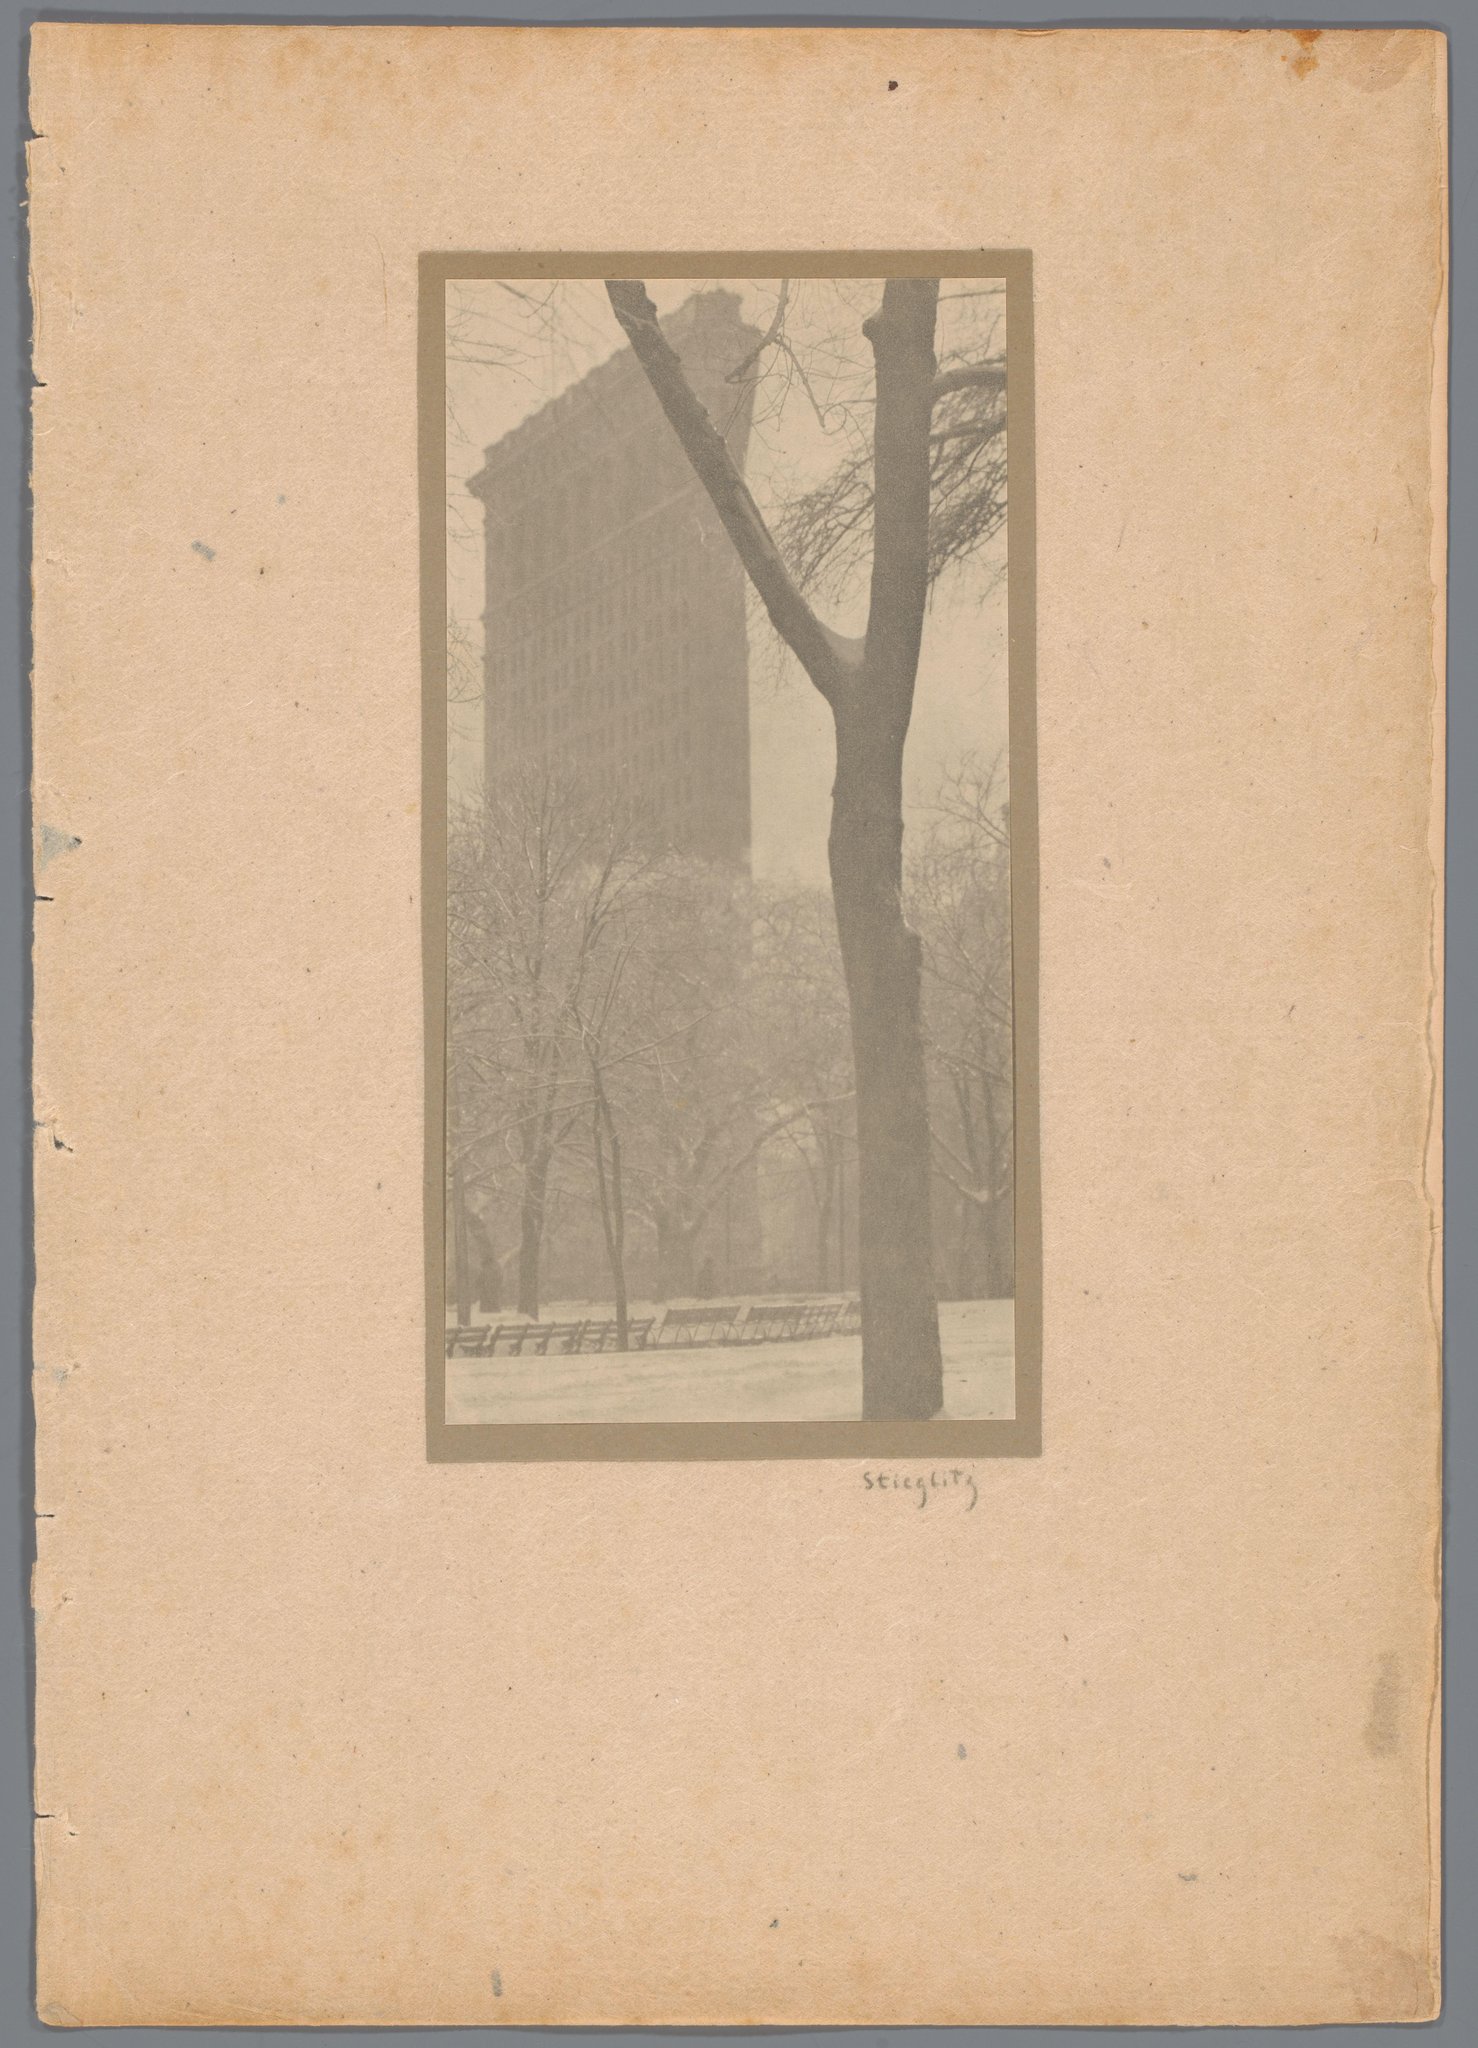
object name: photomechanical print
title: Flatiron Building, New York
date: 1903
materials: cardboard, paper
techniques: photoaquatint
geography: new york city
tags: skyscraper